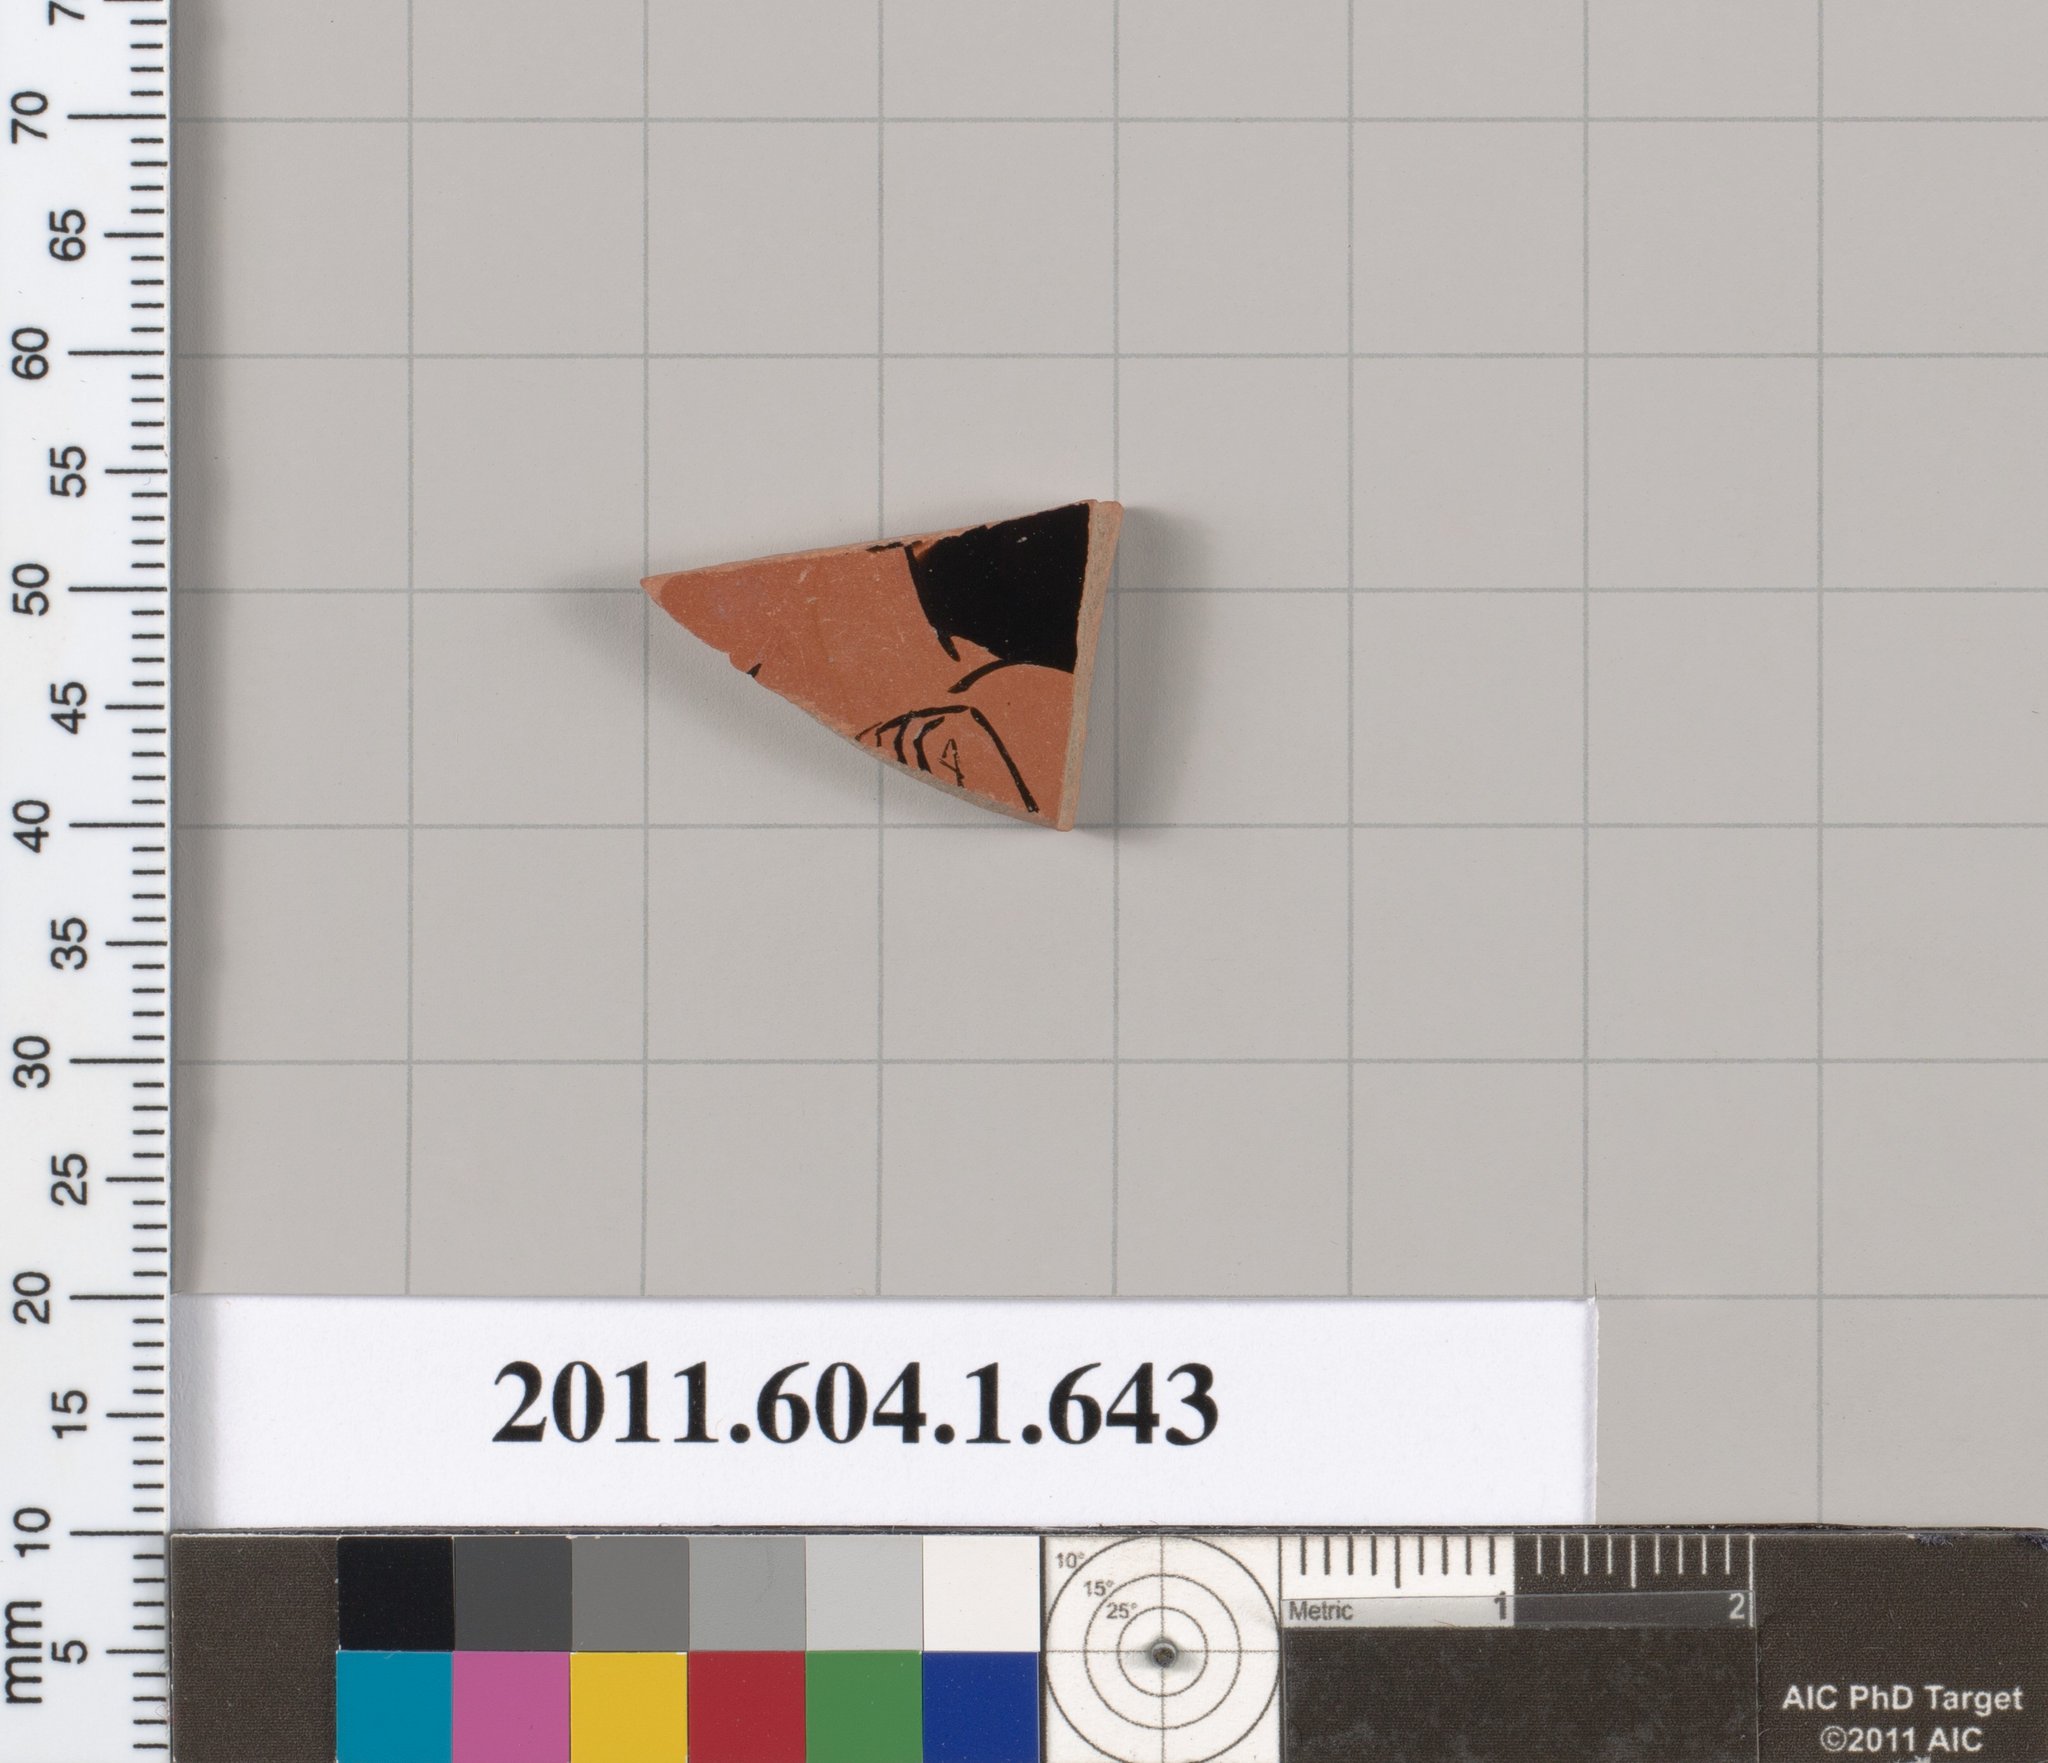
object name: kylix fragment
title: Terracotta fragment of a kylix (drinking cup)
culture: greek, attic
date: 475-451 BCE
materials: terracotta